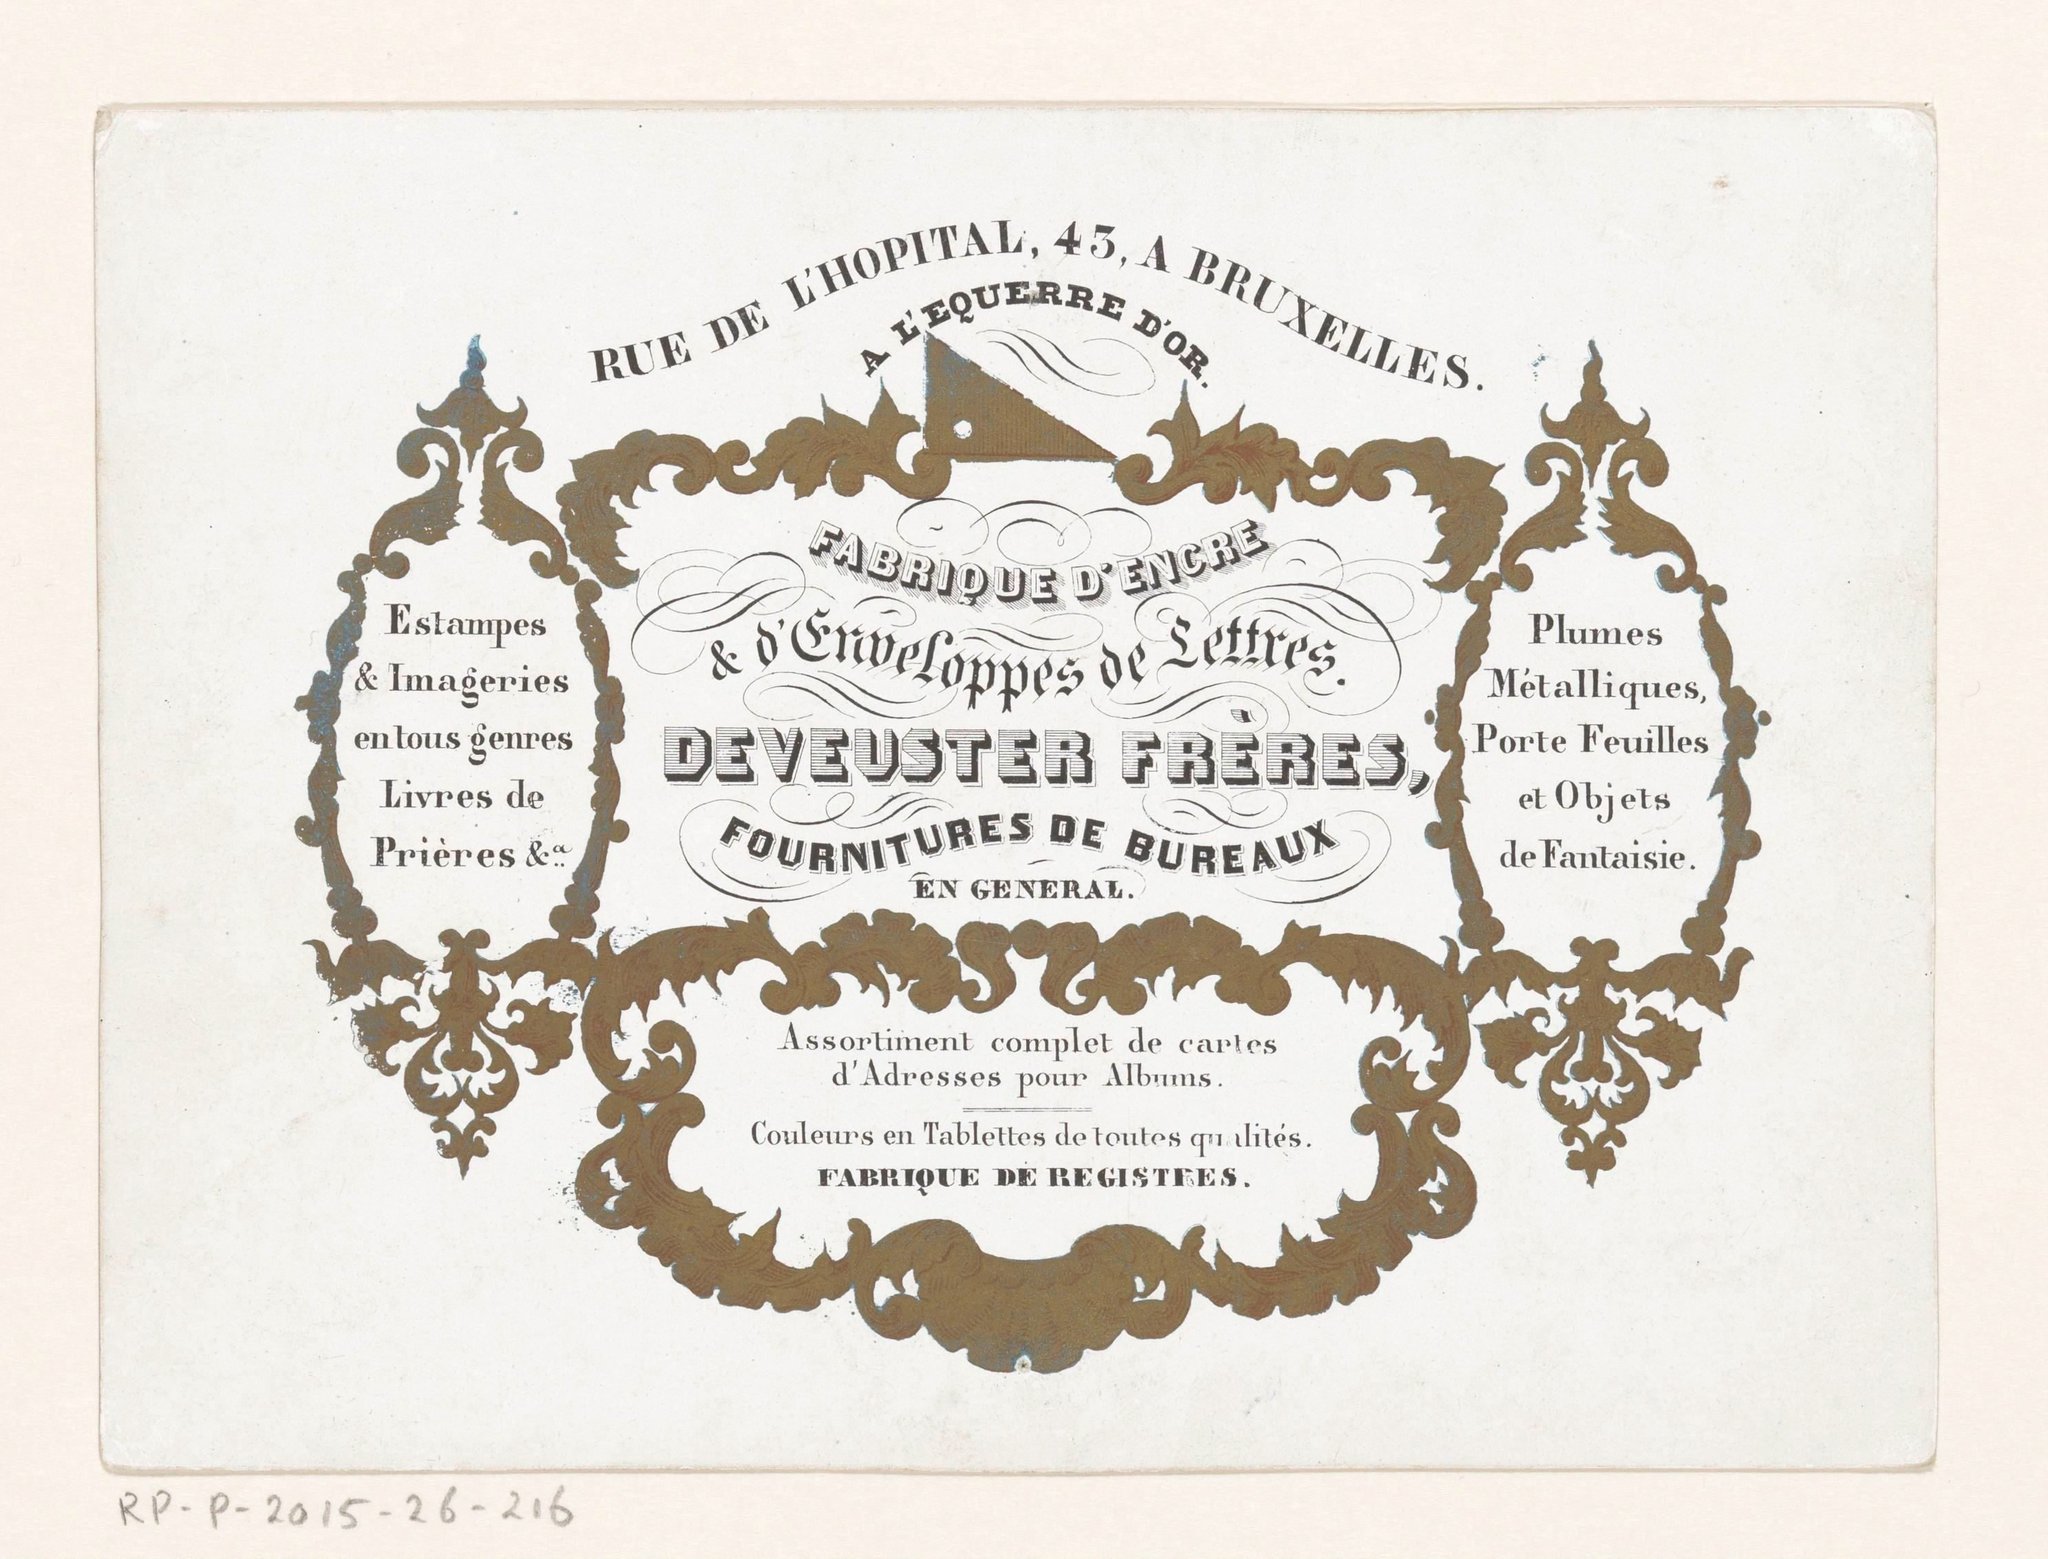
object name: print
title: Visitekaartje van kantoorboekhandel Deveuster Frères te Brussel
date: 1850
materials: porcelainized cardboard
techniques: lithograph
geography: brussels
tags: lithographer, square (drawing-instrument)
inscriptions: collector's mark: Lugt 2228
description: In de omlijsting een winkelhaak, een verwijzing naar het vestigingsadres: "A l'equerre d'or".